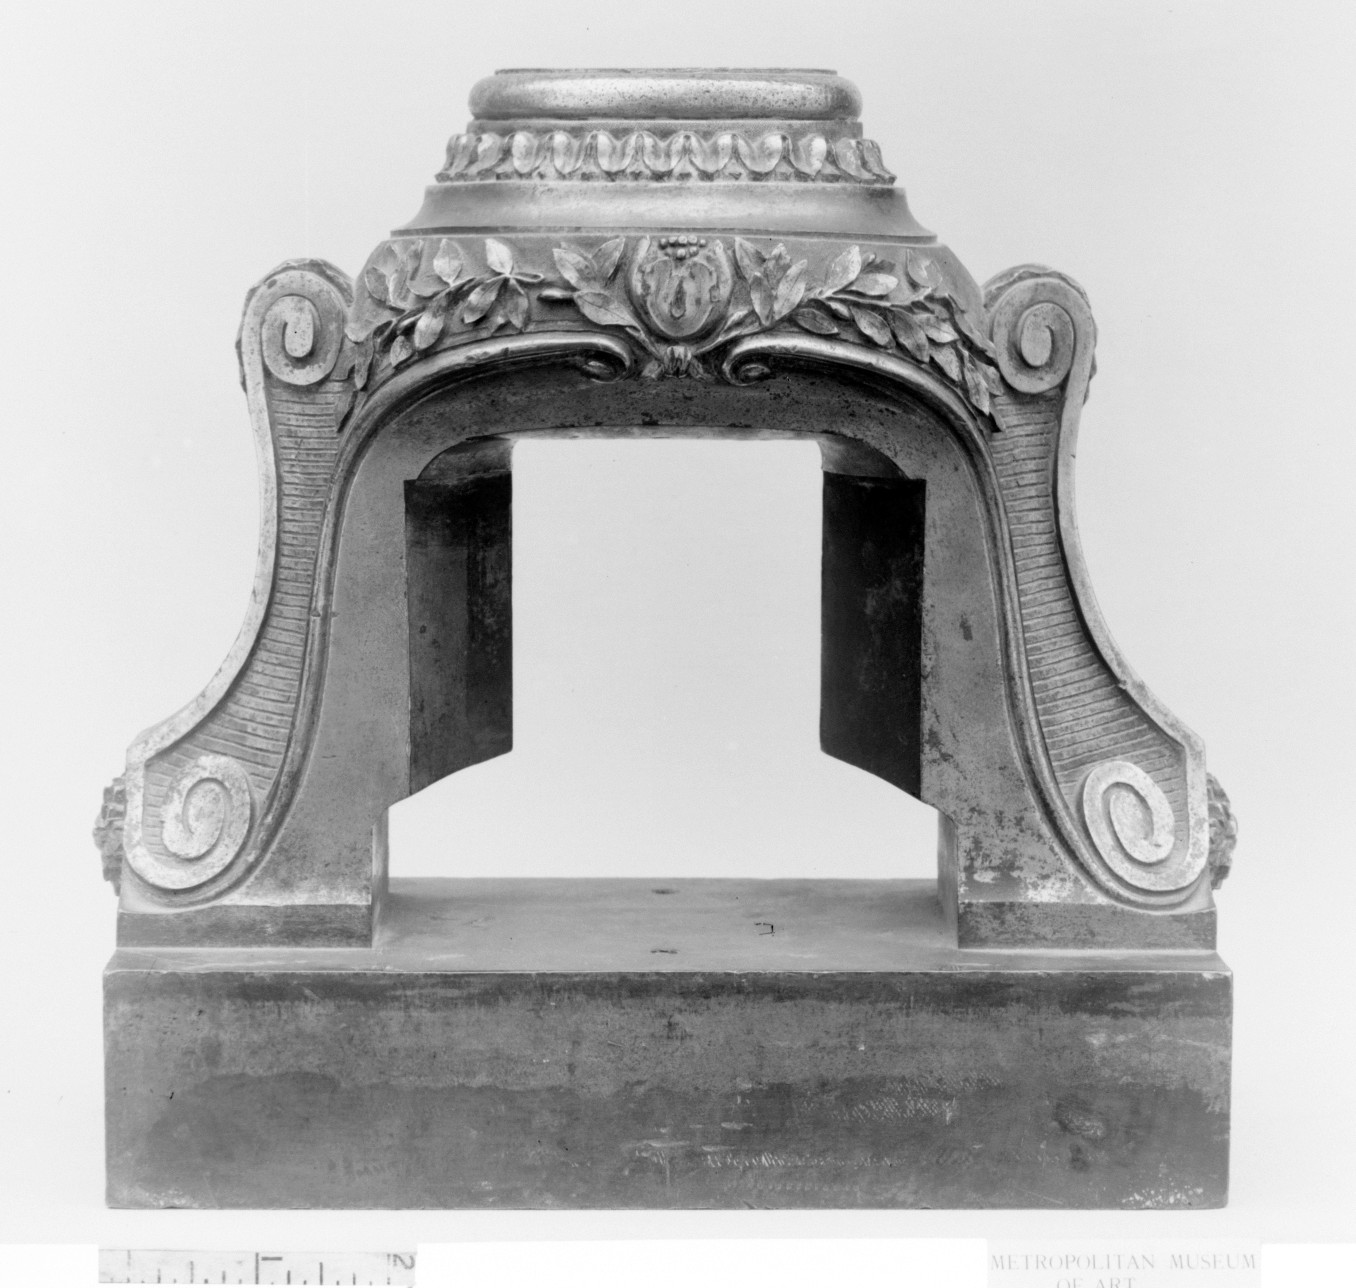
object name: press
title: Press part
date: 1701-1800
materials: gilt bronze